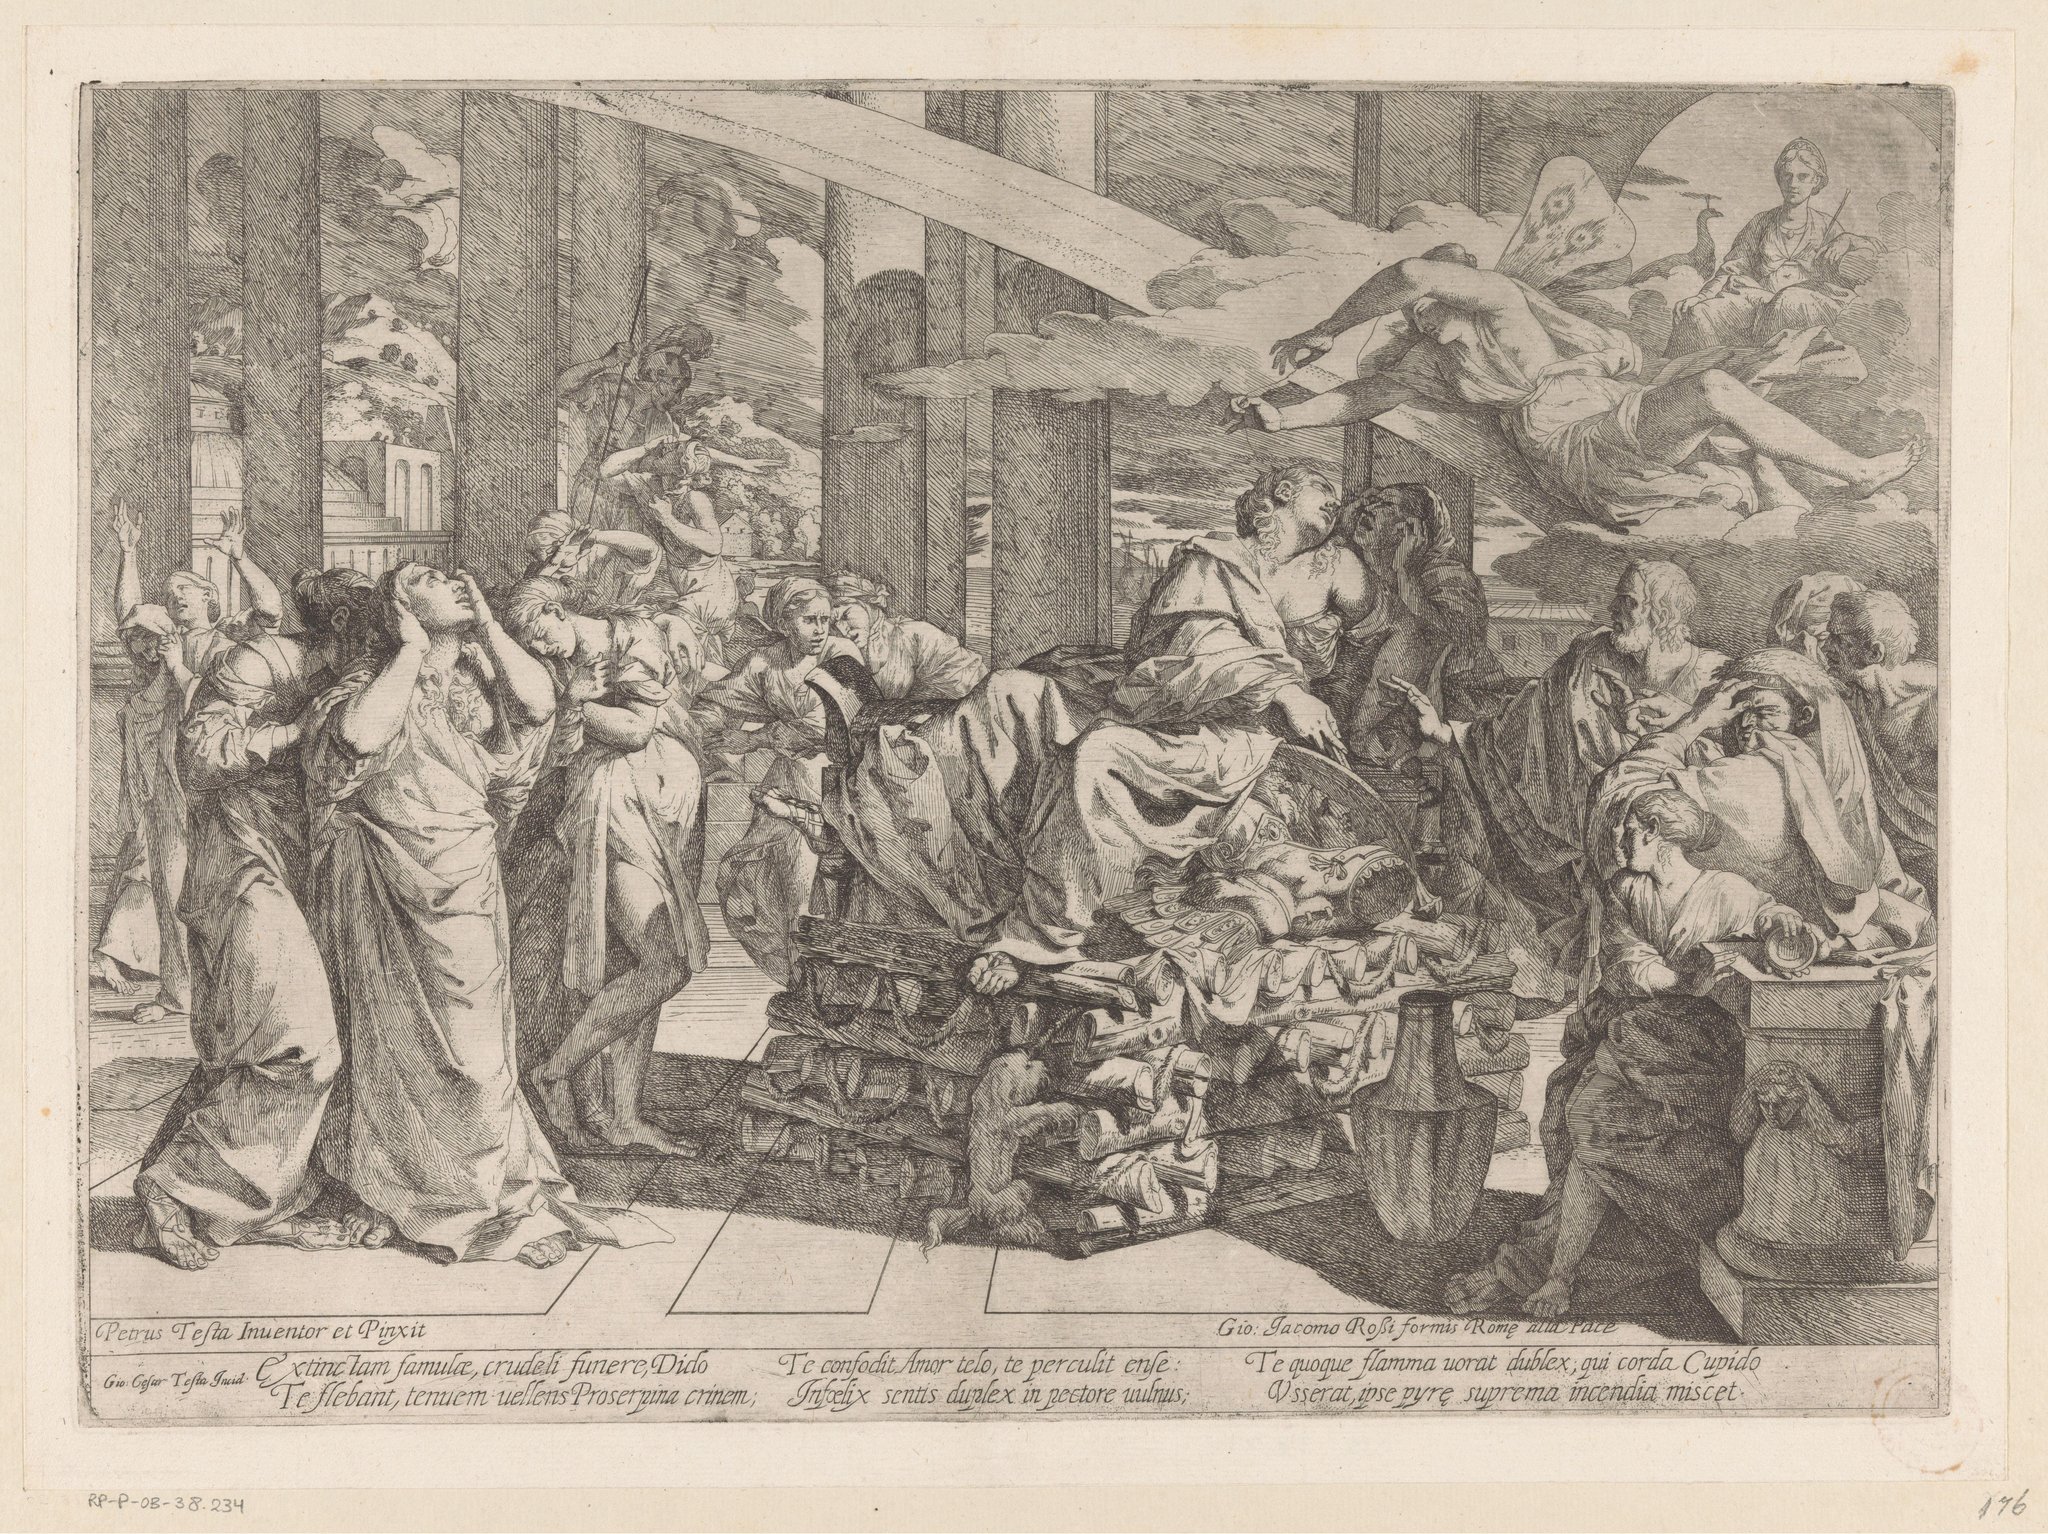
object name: print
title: Dido op de brandstapel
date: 1637-1691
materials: paper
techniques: etching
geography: rome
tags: (story of) dido, death of dido; she climbs the funeral pyre and falls upon the sword of aeneas, iris cuts a lock from dido's hair to release her soul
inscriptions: collector's mark: Lugt 240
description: Koningin Dido ligt op een brandstapel. Rondom staan treurende mannen en vrouwen. Boven Dido zweeft Iris die een haar van Dido neemt om haar ziel vrij te laten. Achter Iris zit Juno met pauw op een wolk. Onderschrift in het Latijn in ondermarge.